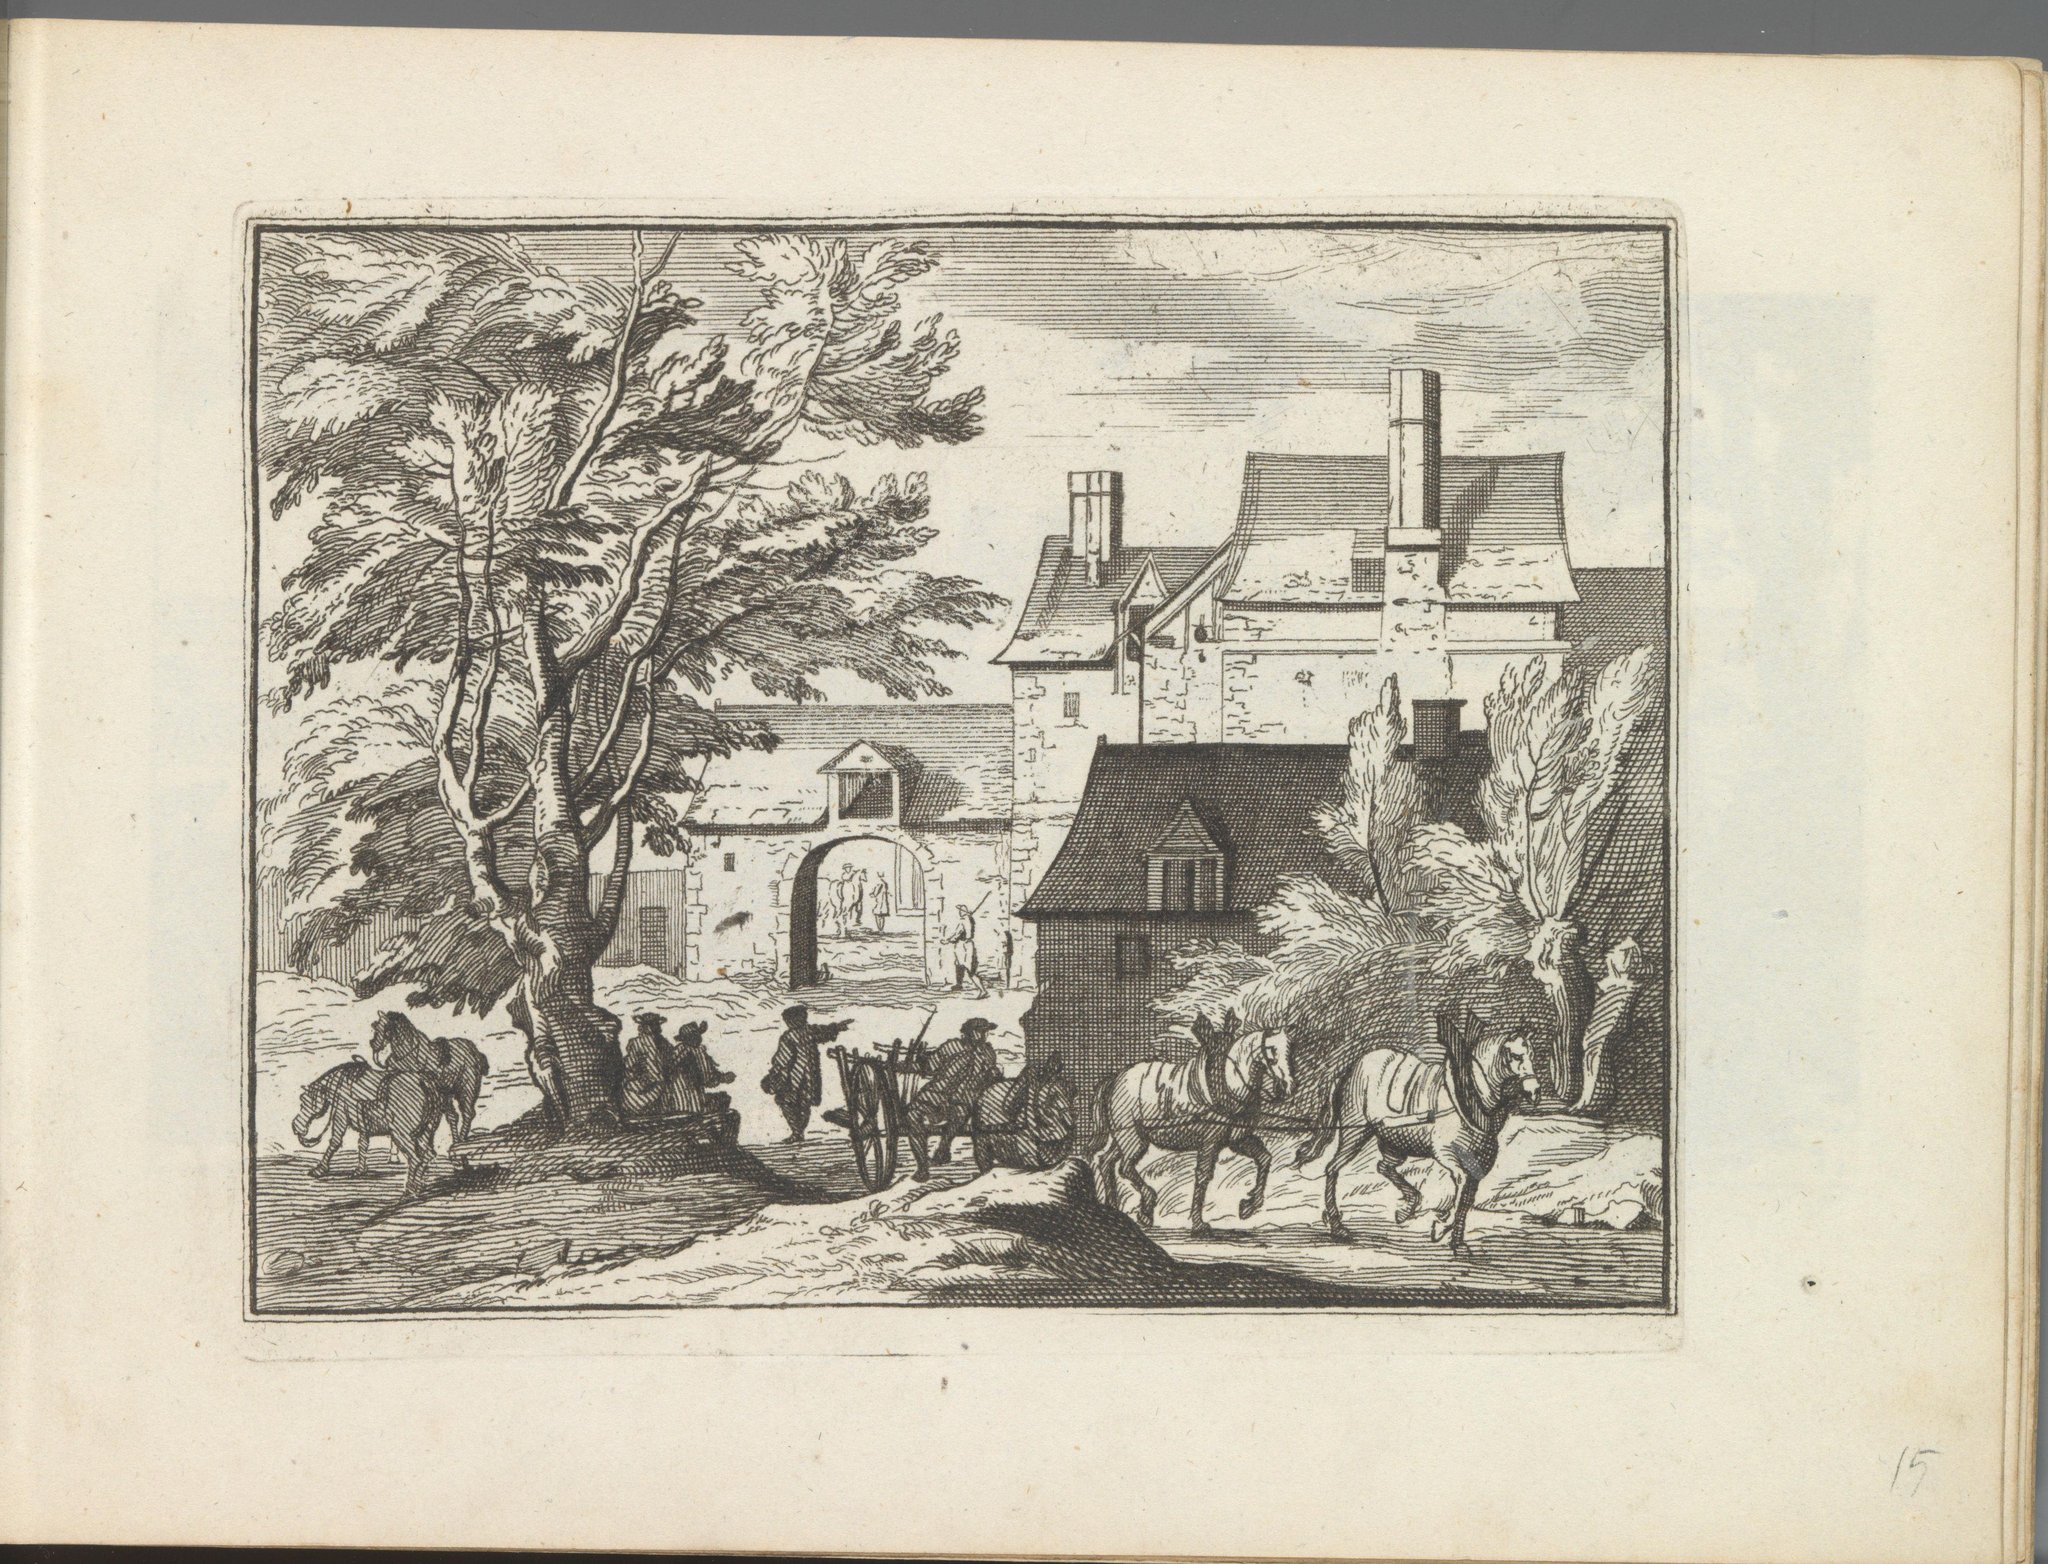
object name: album leaf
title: Gezicht op een stadspoort met paard en wagen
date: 1600-1699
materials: paper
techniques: etching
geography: amsterdam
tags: four-wheeled vehicle drawn by three animals, landscapes in the temperate zone, city-gate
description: Gezicht op een stadspoort met daarvoor een wagen getrokken door drie paarden. Links bij een boom grazen twee paarden. De prent maakt deel uit van een album.